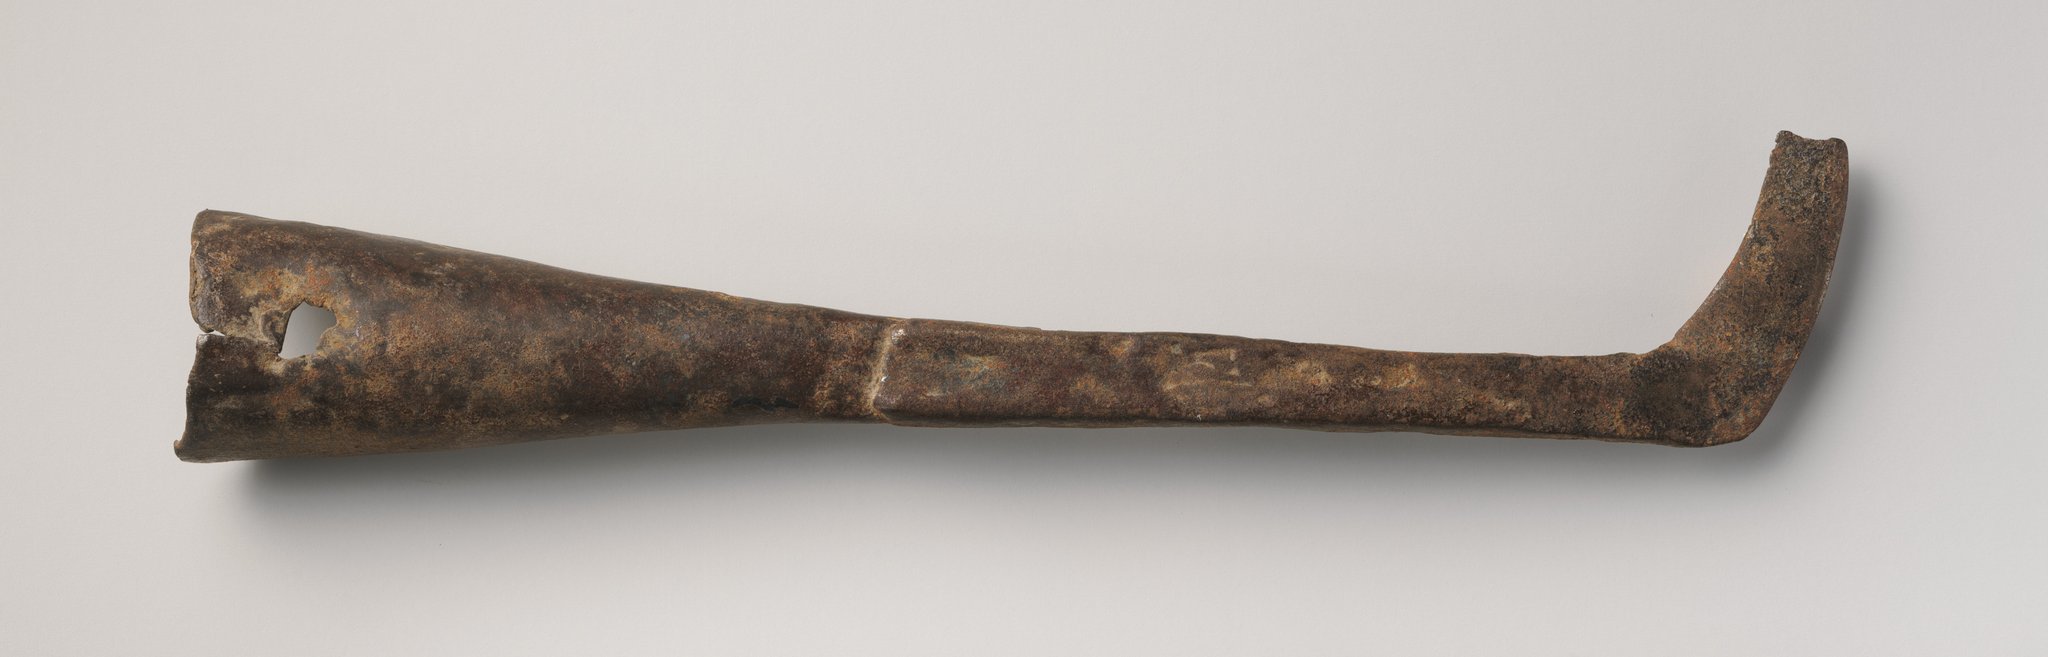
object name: knife end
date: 306-30 BCE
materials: bronze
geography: egypt